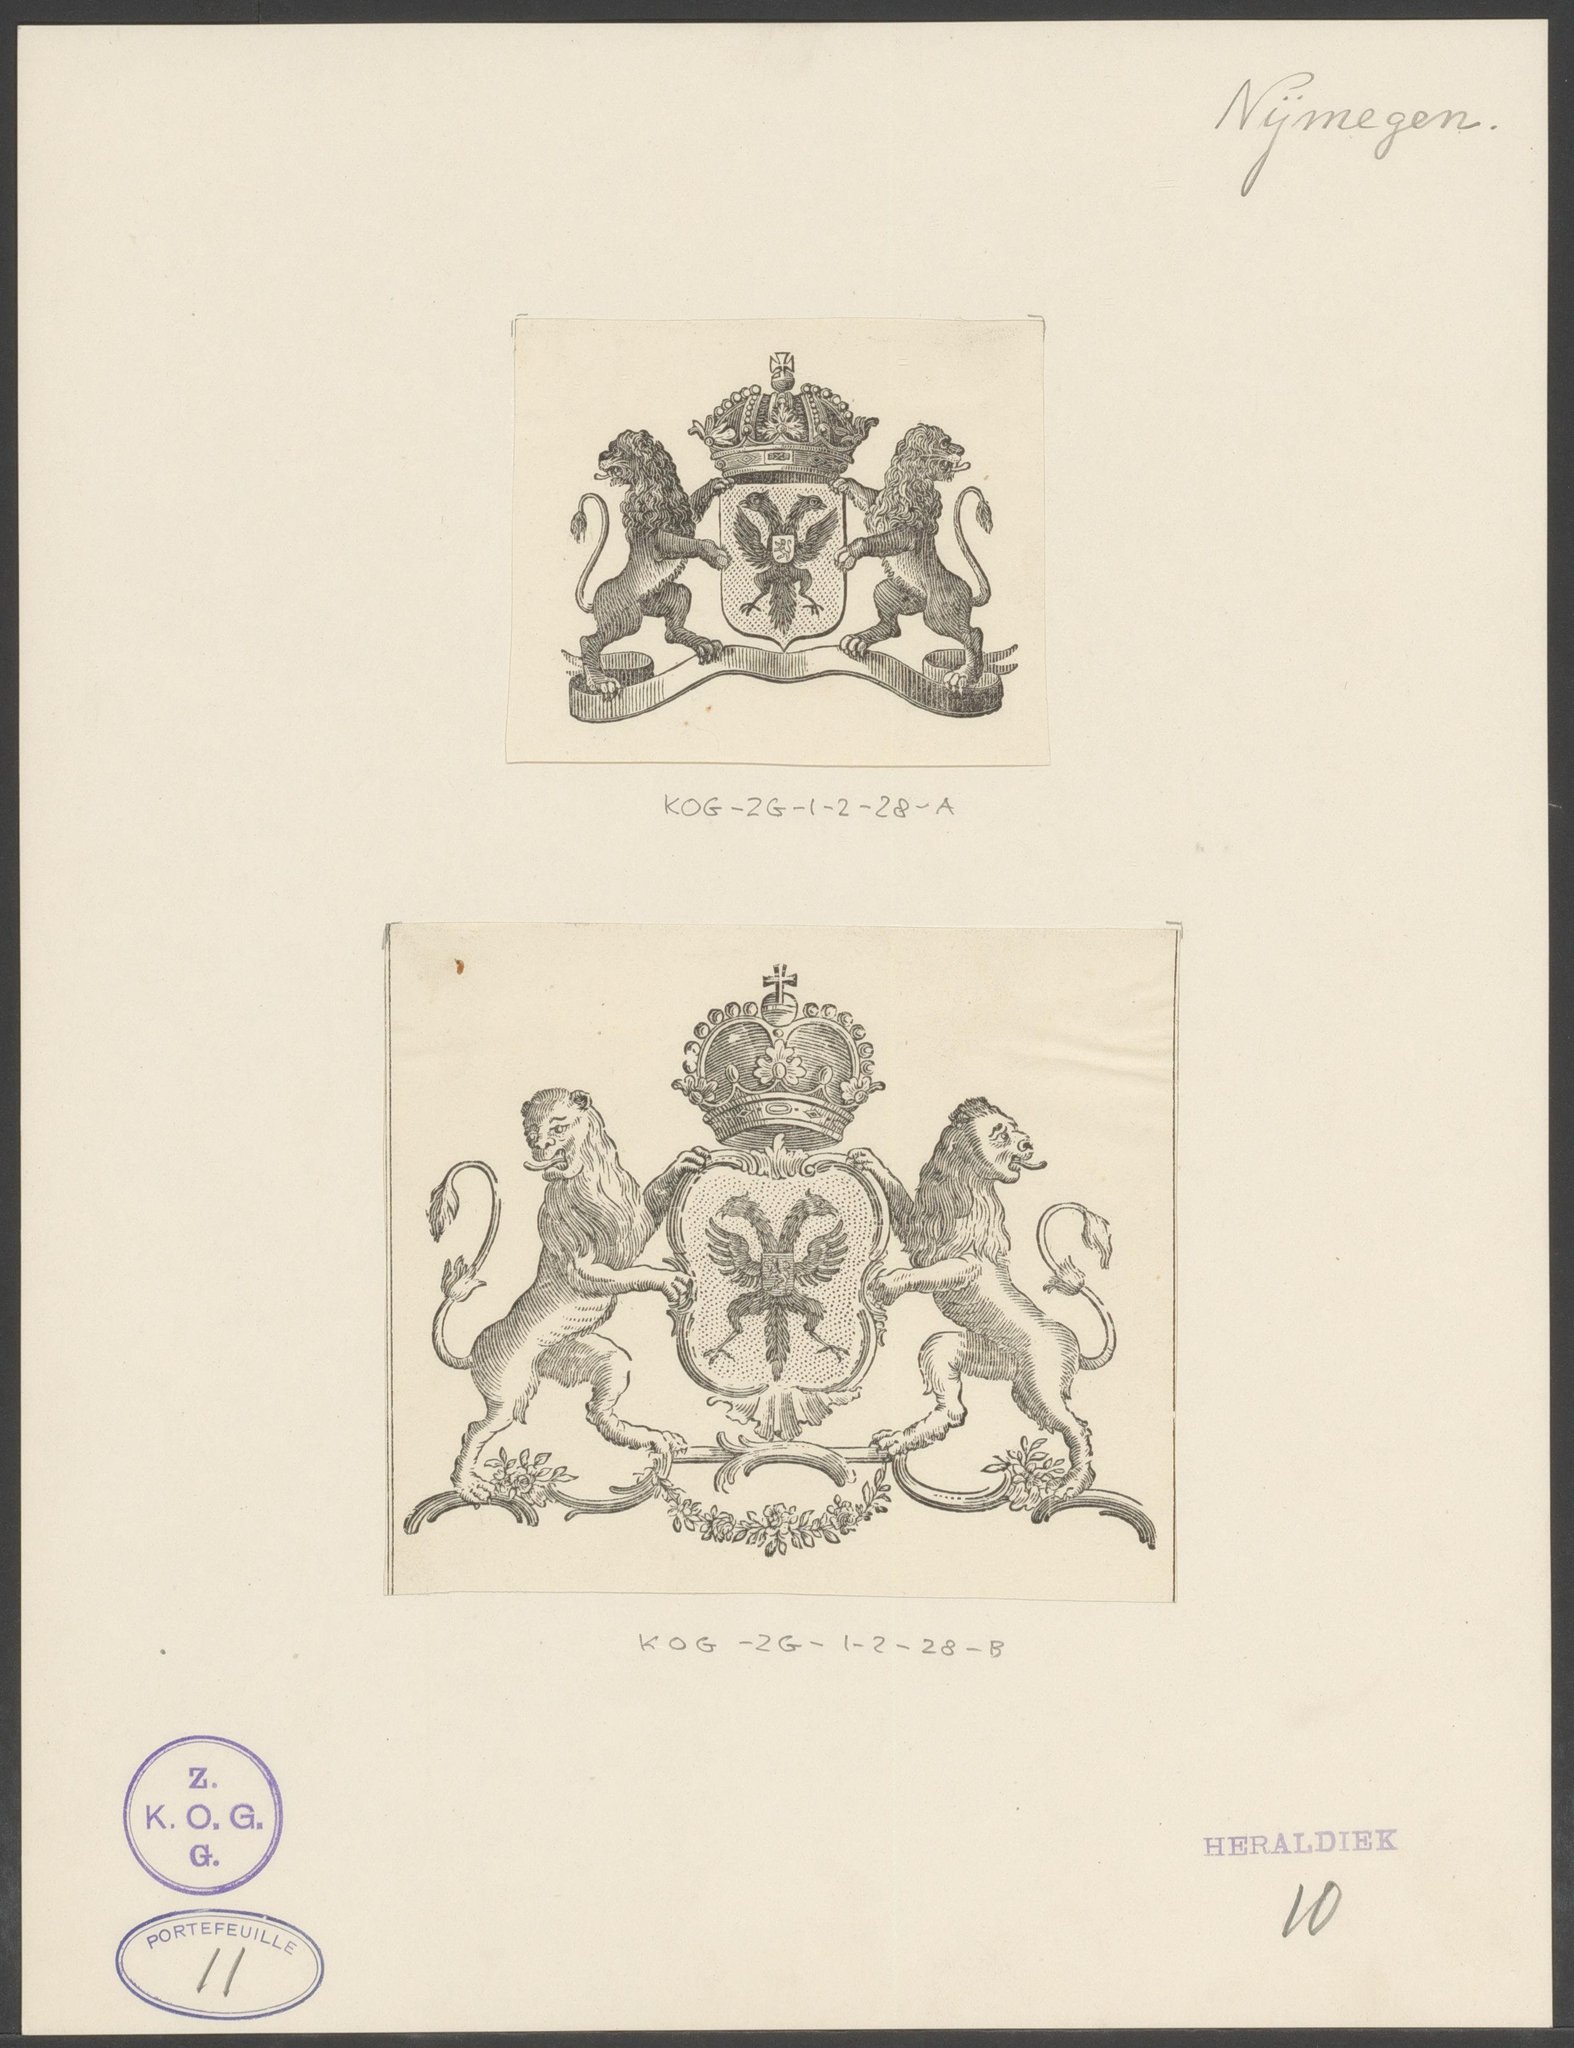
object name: print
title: Wapen van Nijmegen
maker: Anonymous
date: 1800-1899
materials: paper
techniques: woodcut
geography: netherlands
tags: coat of arms (as symbol of the state, etc.) (+ city; municipal), nijmegen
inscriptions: collector's mark, collector's mark: Lugt 1641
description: Stadswapen van Nijmegen, met leeuwen als schildhouders. Onderwerpsrubrieken binnen de Atlas Zeden en Gewoonten: Regeering, Wapens, Heraldiek, Steden.